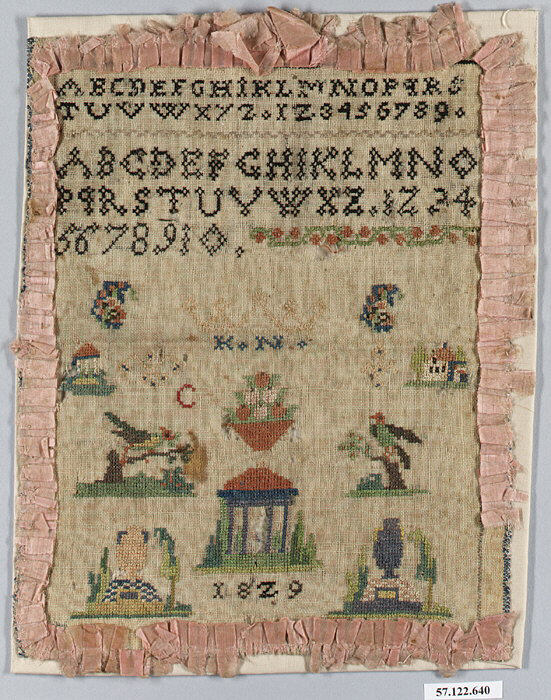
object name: sampler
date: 1829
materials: silk, wool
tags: birds,houses